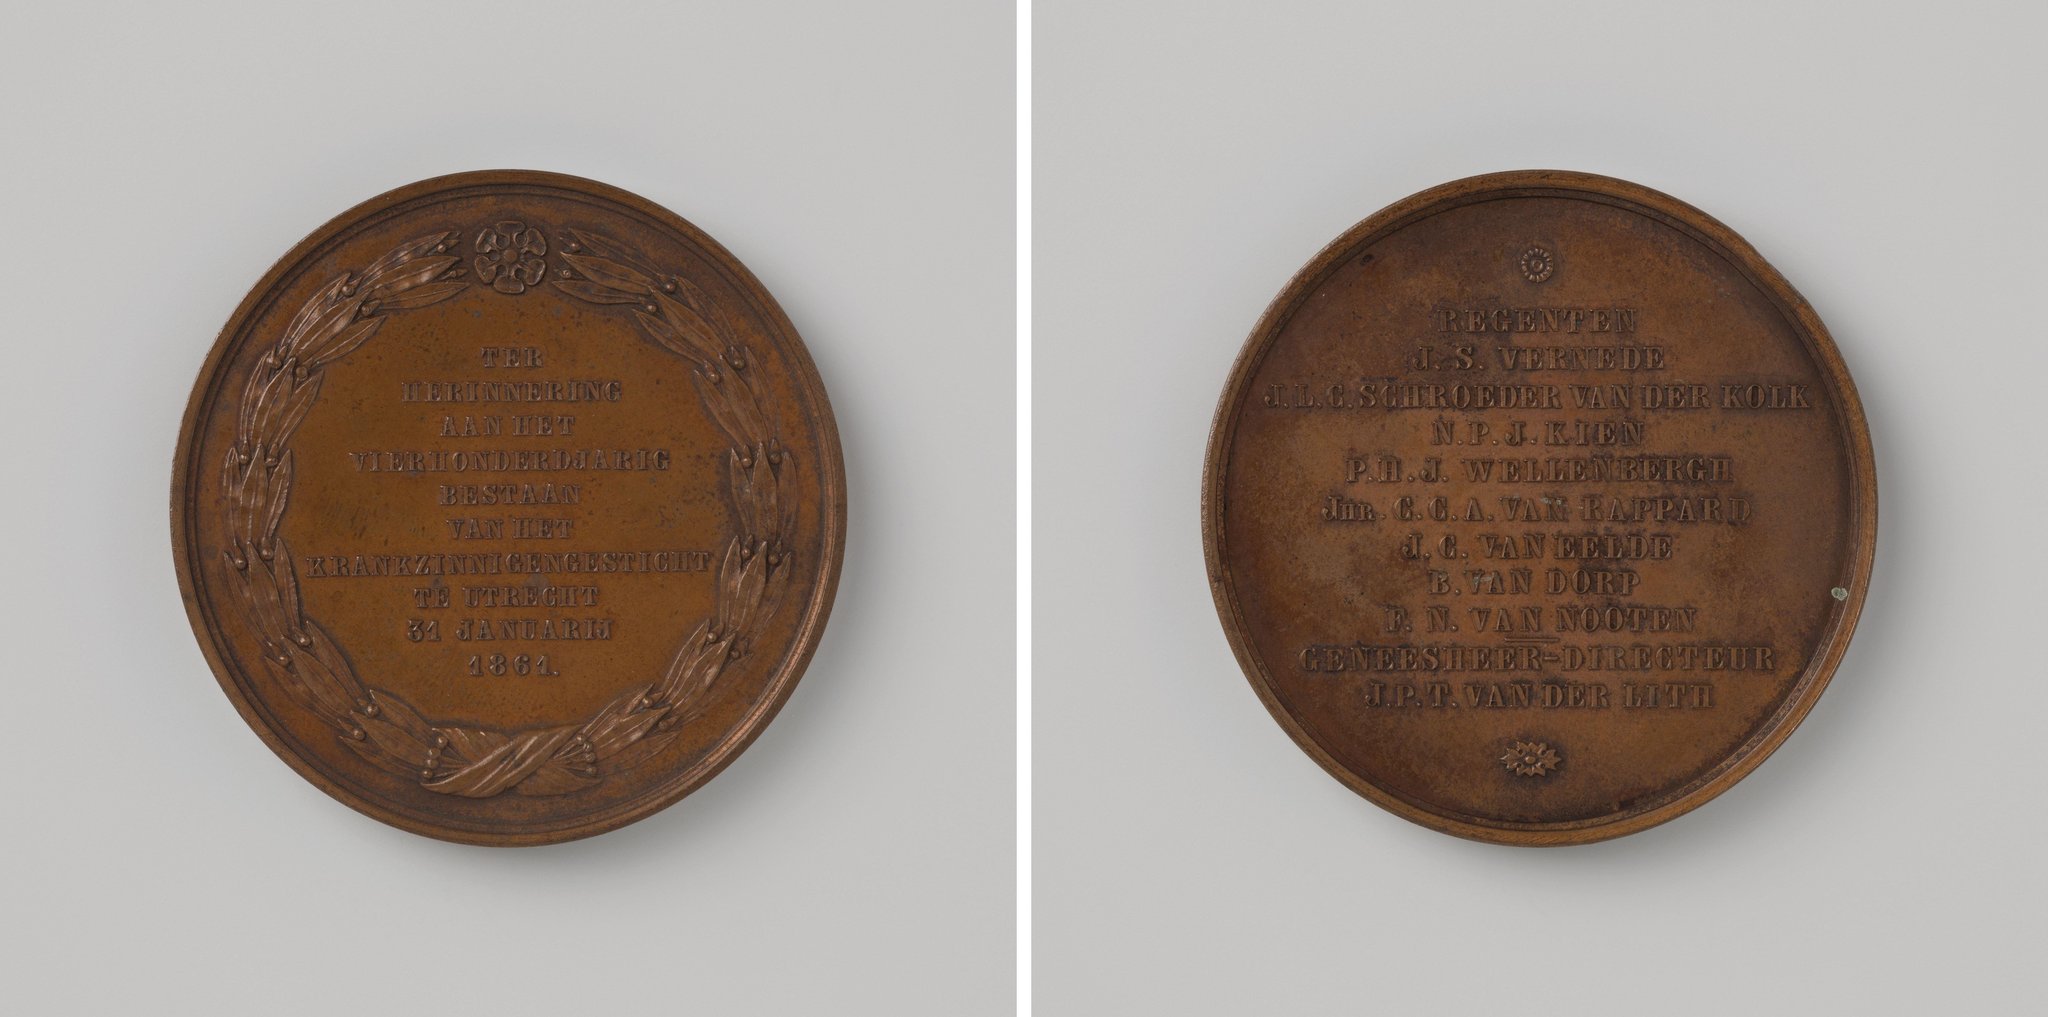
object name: history medal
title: Vierhonderdjarig bestaan van het Krankzinnigengesticht te Utrecht 1861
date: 1861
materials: bronze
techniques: striking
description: Bronzen penning, op de voorzijde tien regels tekst binnen een lauwerkrans, op de keerzijde elf regels tekst.